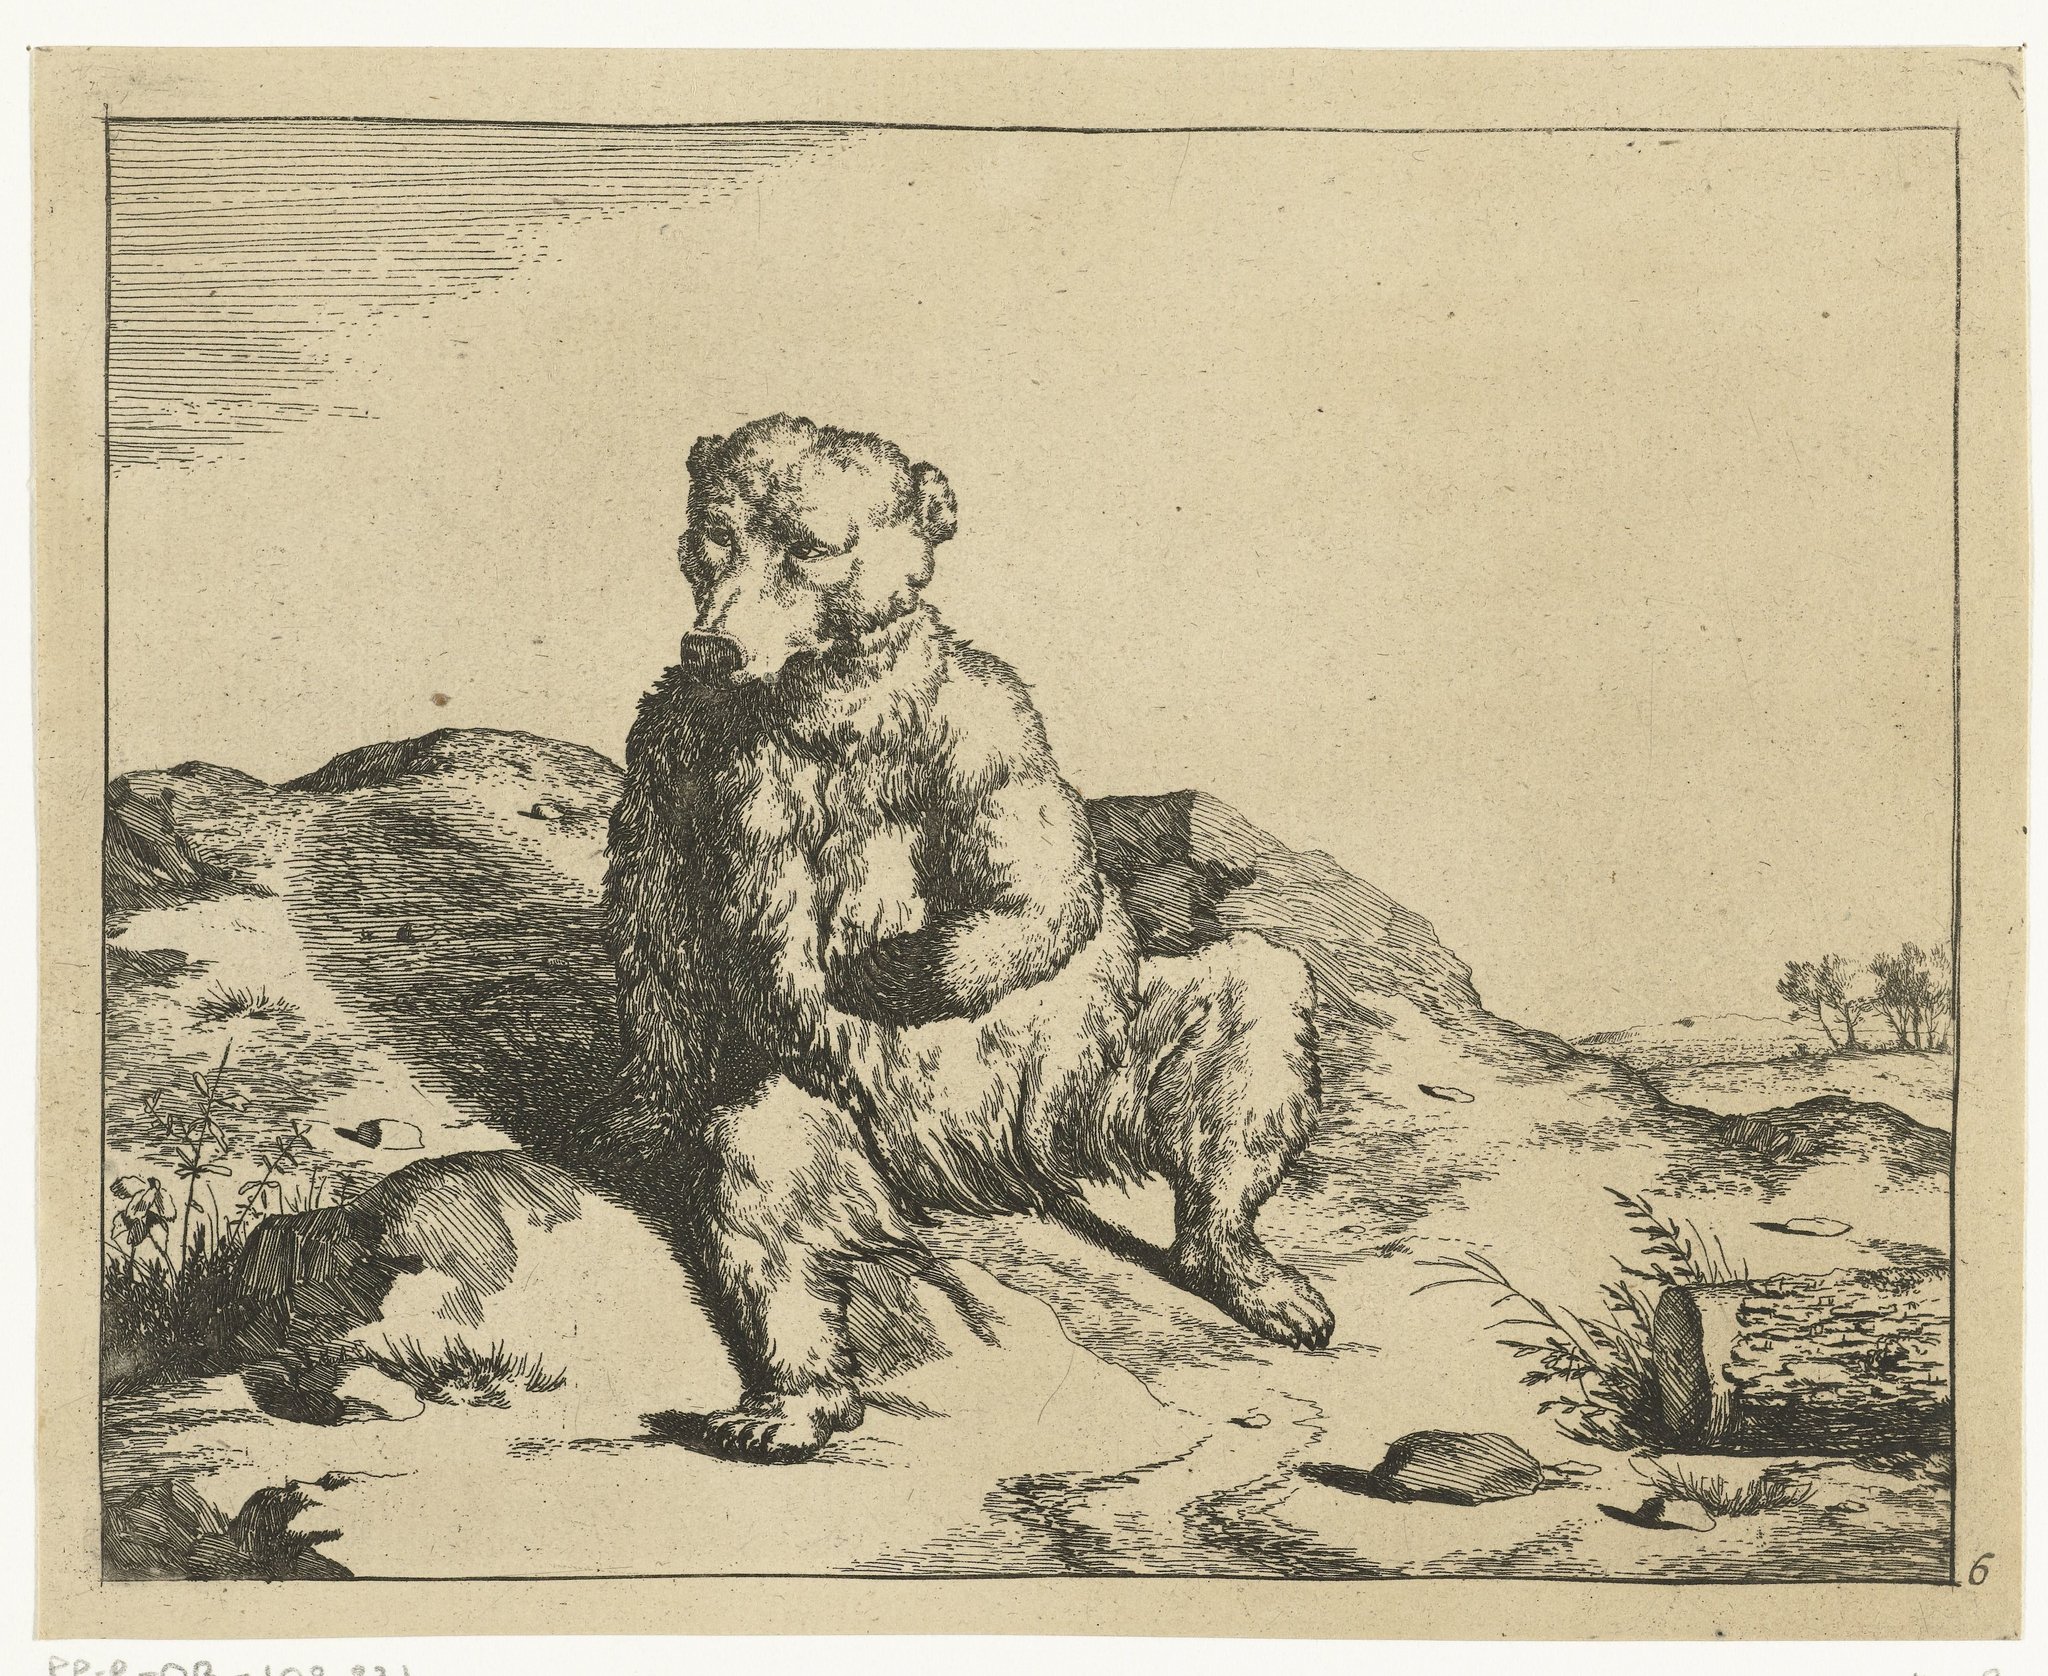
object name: print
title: Roofdieren en zwijnen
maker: marcus de bye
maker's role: print maker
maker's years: 1639-1688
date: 1657-1677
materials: paper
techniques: etching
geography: the hague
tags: beasts of prey, predatory animals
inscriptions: collector's mark: Lugt 2228